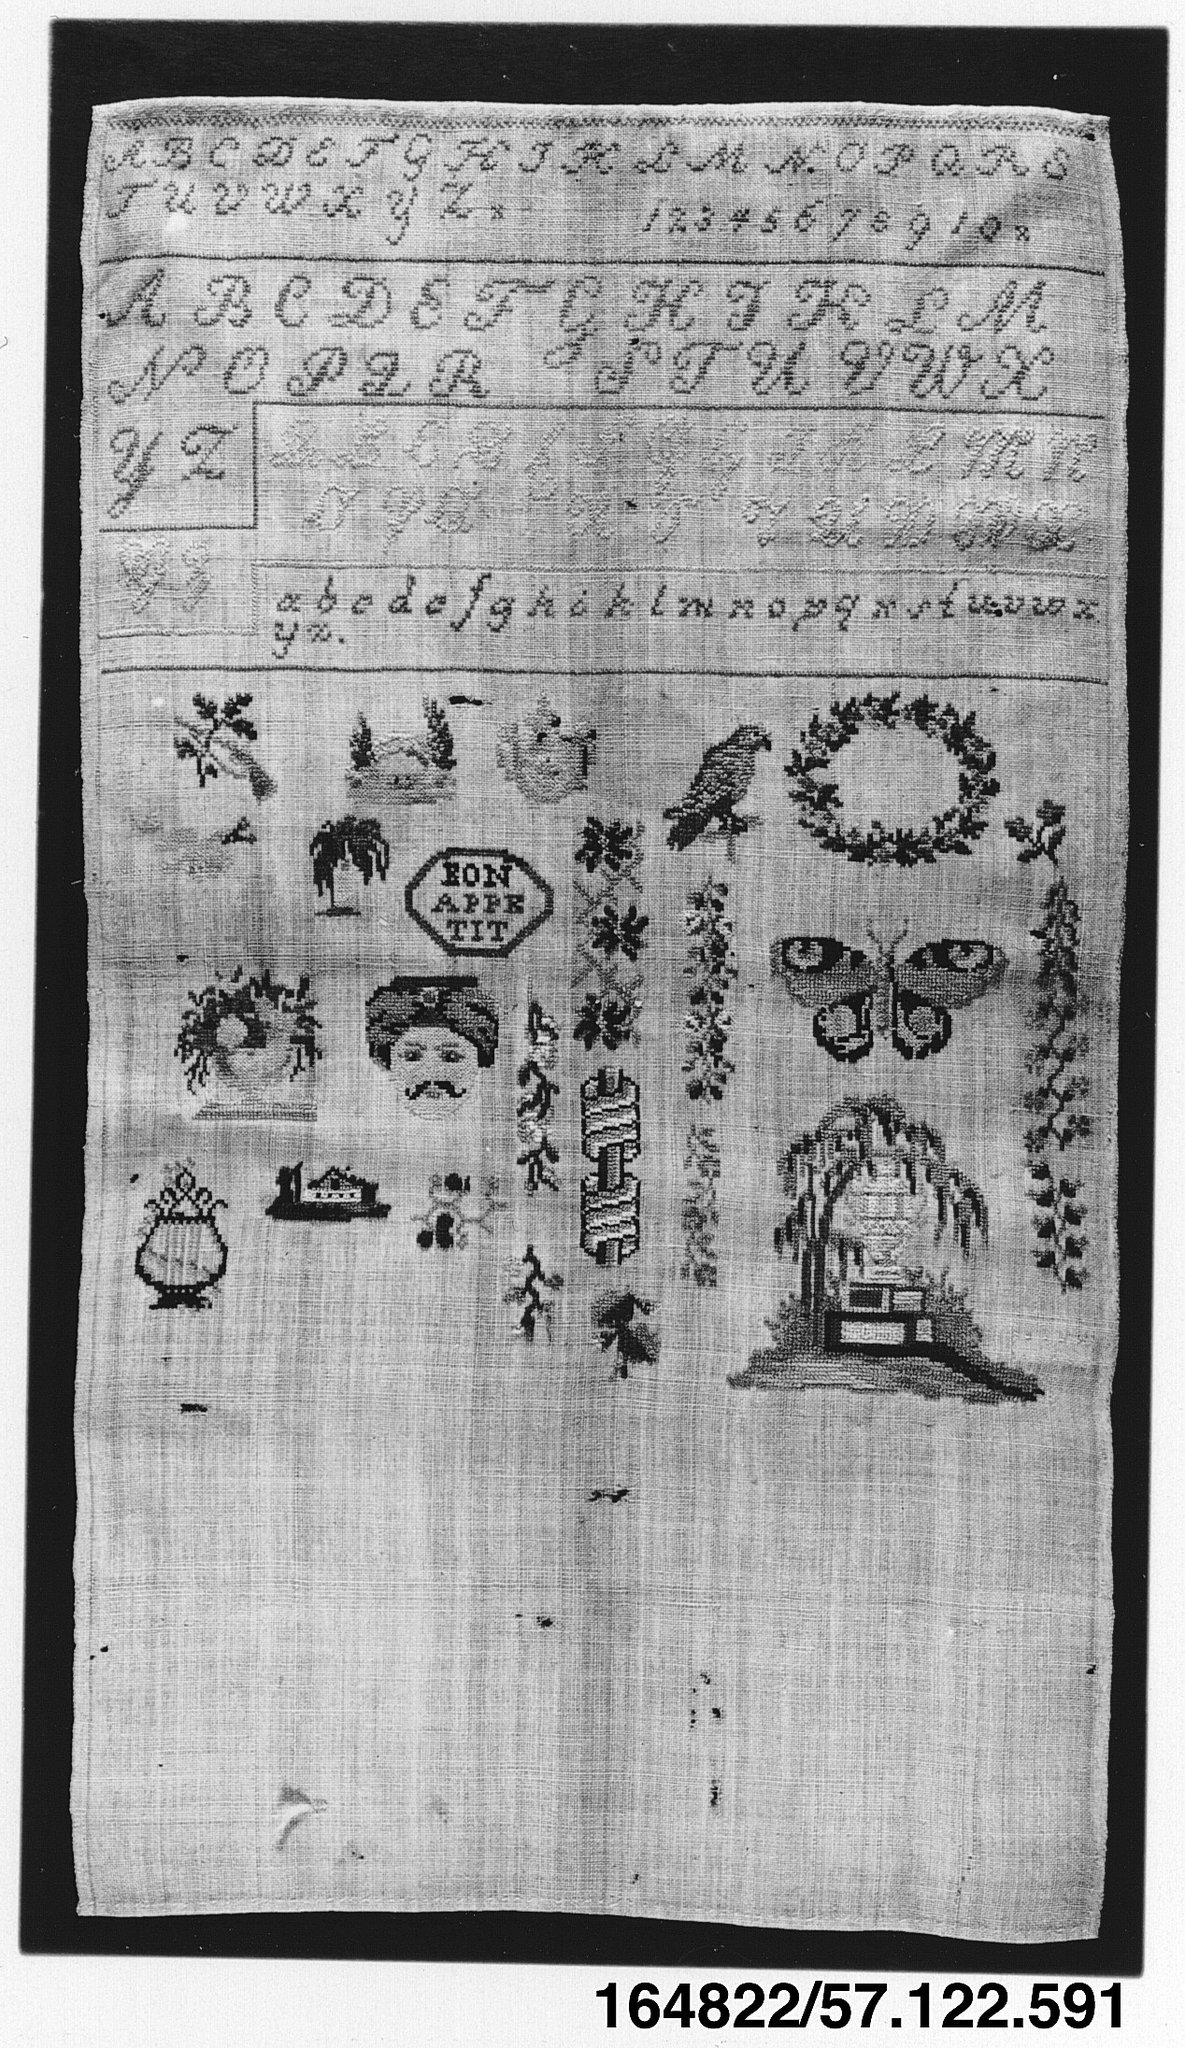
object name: sampler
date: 1801-1900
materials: silk, wool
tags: garlands,faces,parrots,butterflies